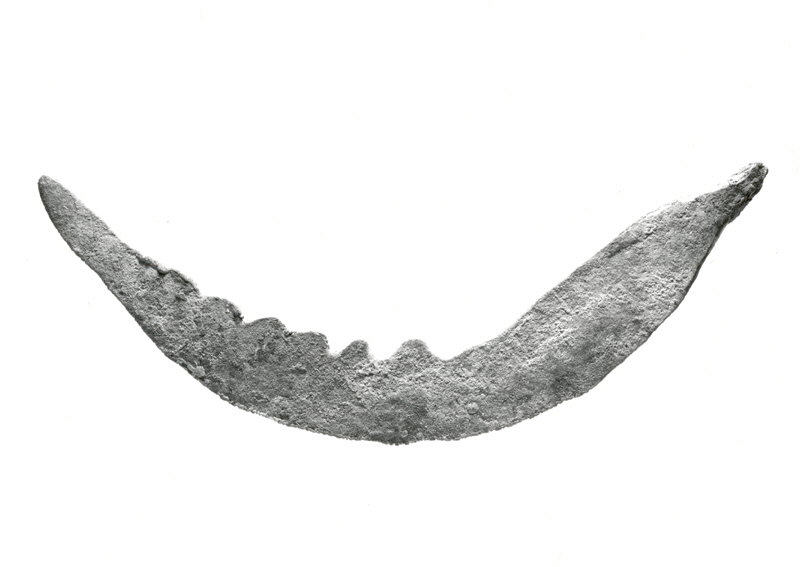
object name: knife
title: Blade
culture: bactria-margiana archaeological complex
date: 2333-1668 BCE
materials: copper alloy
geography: bactria-margiana